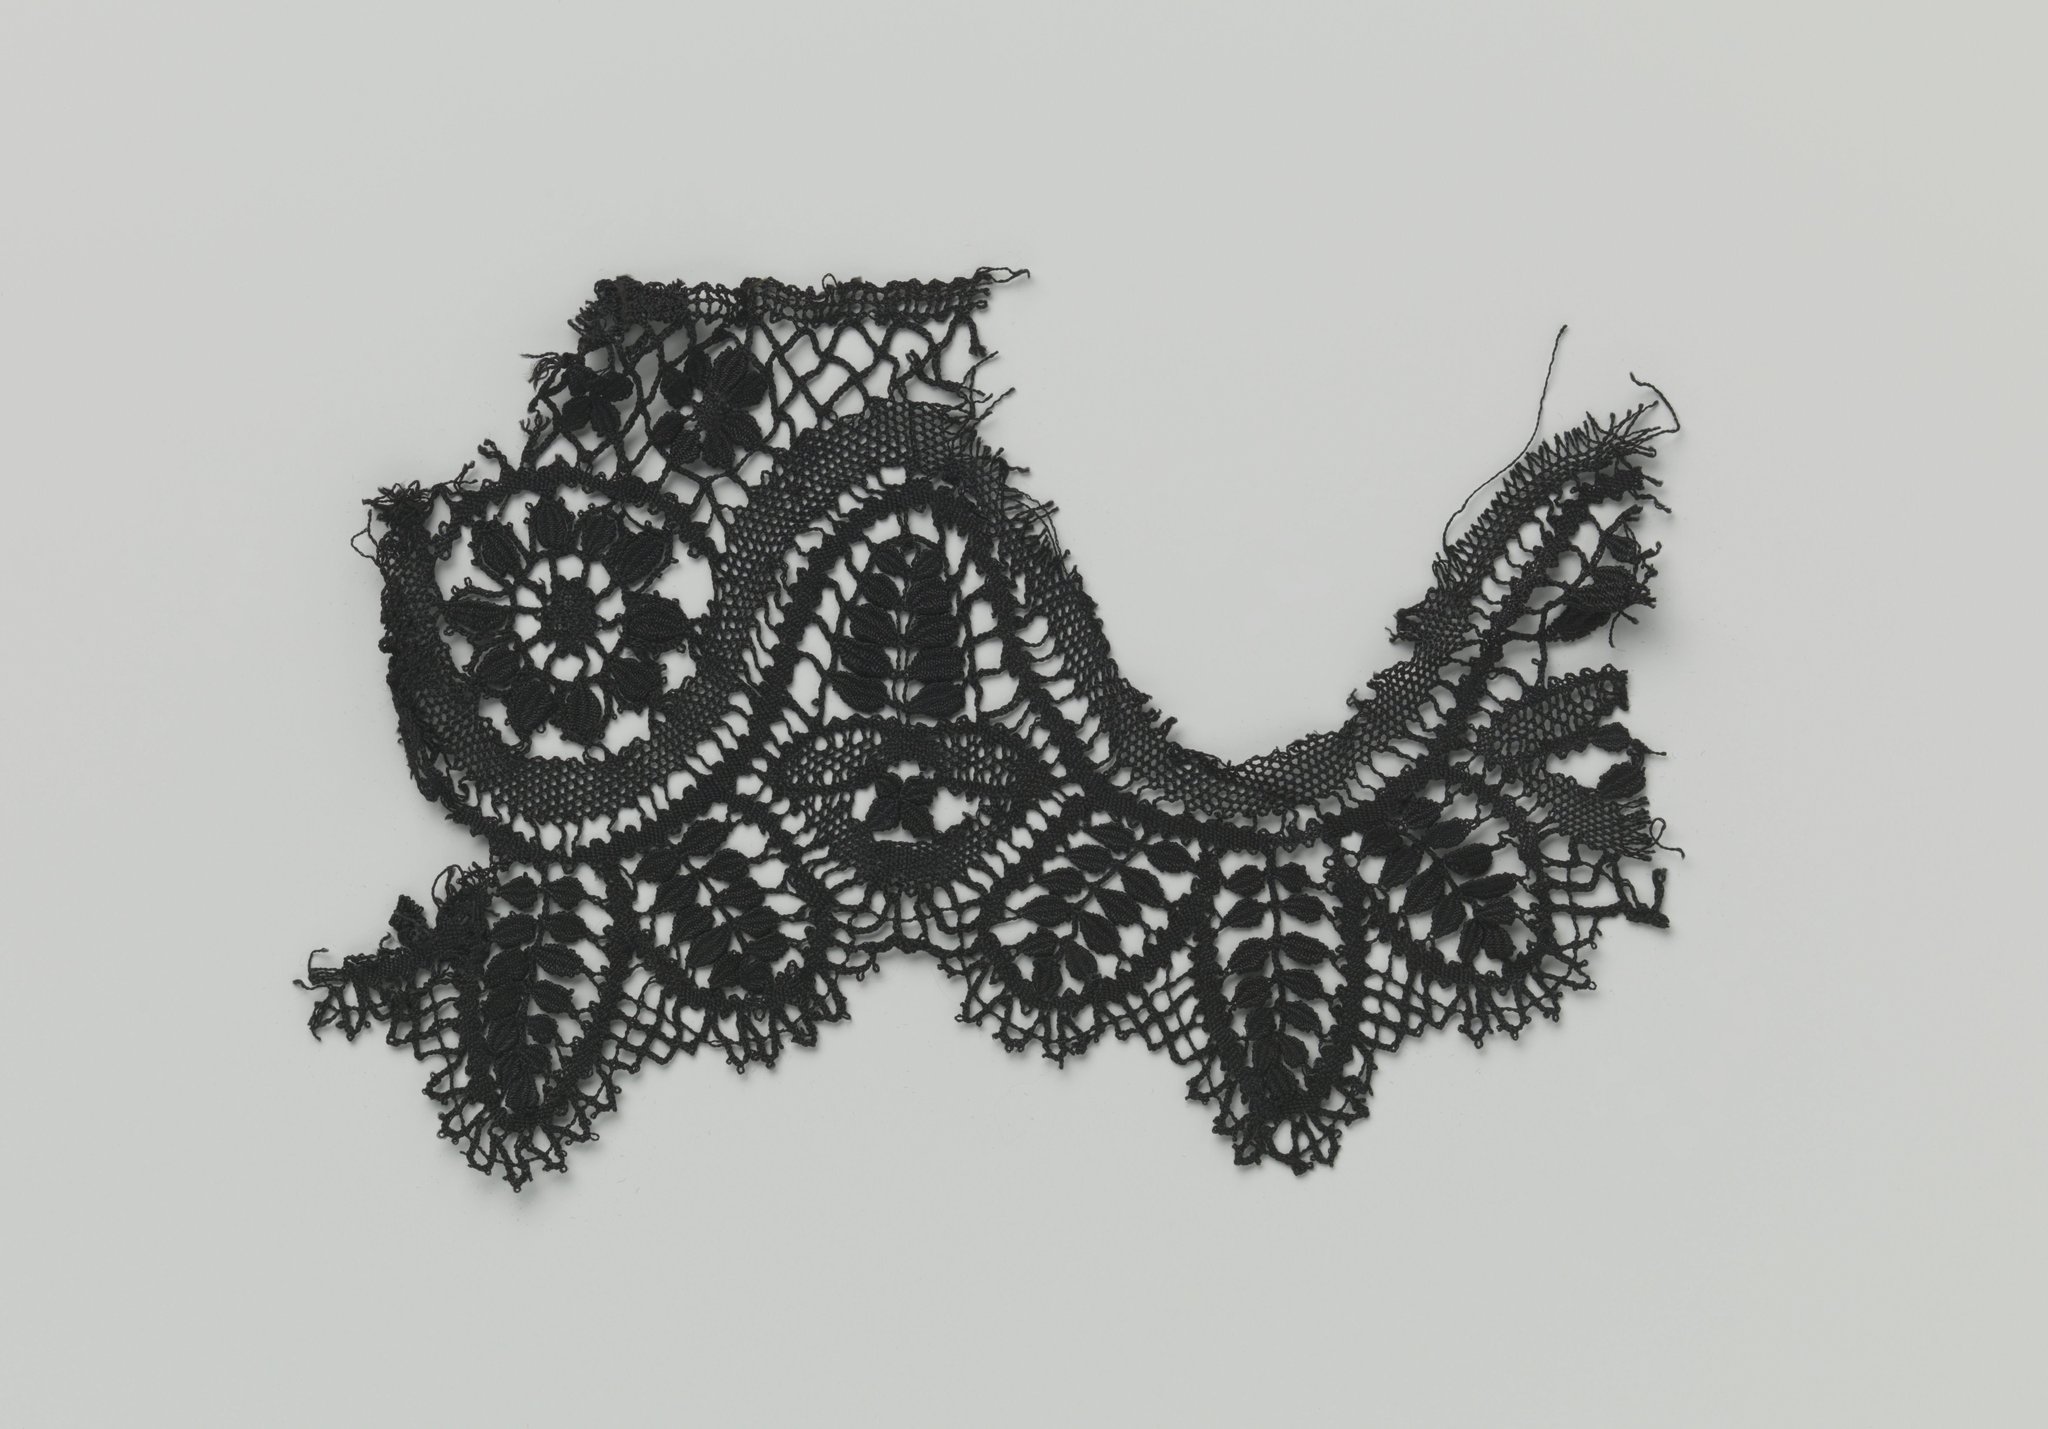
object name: strip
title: Strook kloskant met diepe golflijn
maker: Anonymous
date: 1880-1899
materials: silk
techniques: lace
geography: geraardsbergen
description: Strook zwarte kloskant, Cluny-kant. De strook is verknipt, één rapport is net niet helemaal meer compleet, het bovenste deel van het daaropvolgende rapport is weggeknipt langs de golflijn. Het oorspronkelijke, zich herhalende en symmetrische patroon bestaat uit een diepe golflijn. In elk golfdal staat een rozet met daarboven twee kleinere rozetten en een vierpuntig sterretje ertussen. Elke golftop omvat een samengesteld, staand blad, met aan weerszijden vijf blaadjes. Onder het blad staat een omlijst vierpuntig sterretje. De schulpenrand langs de onderzijde van de strook wordt gevormd door drie uitstralende lobben onder elk golfdal. In elk van deze lobben hangt een samengesteld blad naar beneden. De lobben zijn afgewerkt met boogjes gemaakt met gepicoteerde vlechtjes. De golflijnen en omlijstingen zijn gemaakt in netslag en linnenslag, de rozetblaadjes, samengestelde bladeren en sterren in vormslag. Ze zijn met elkaar verbonden door een vlechtengrond, die een grove vierkante tralie vormt aan de bovenzijde van de strook. De bovenzijde van de strook is recht afgewerkt.